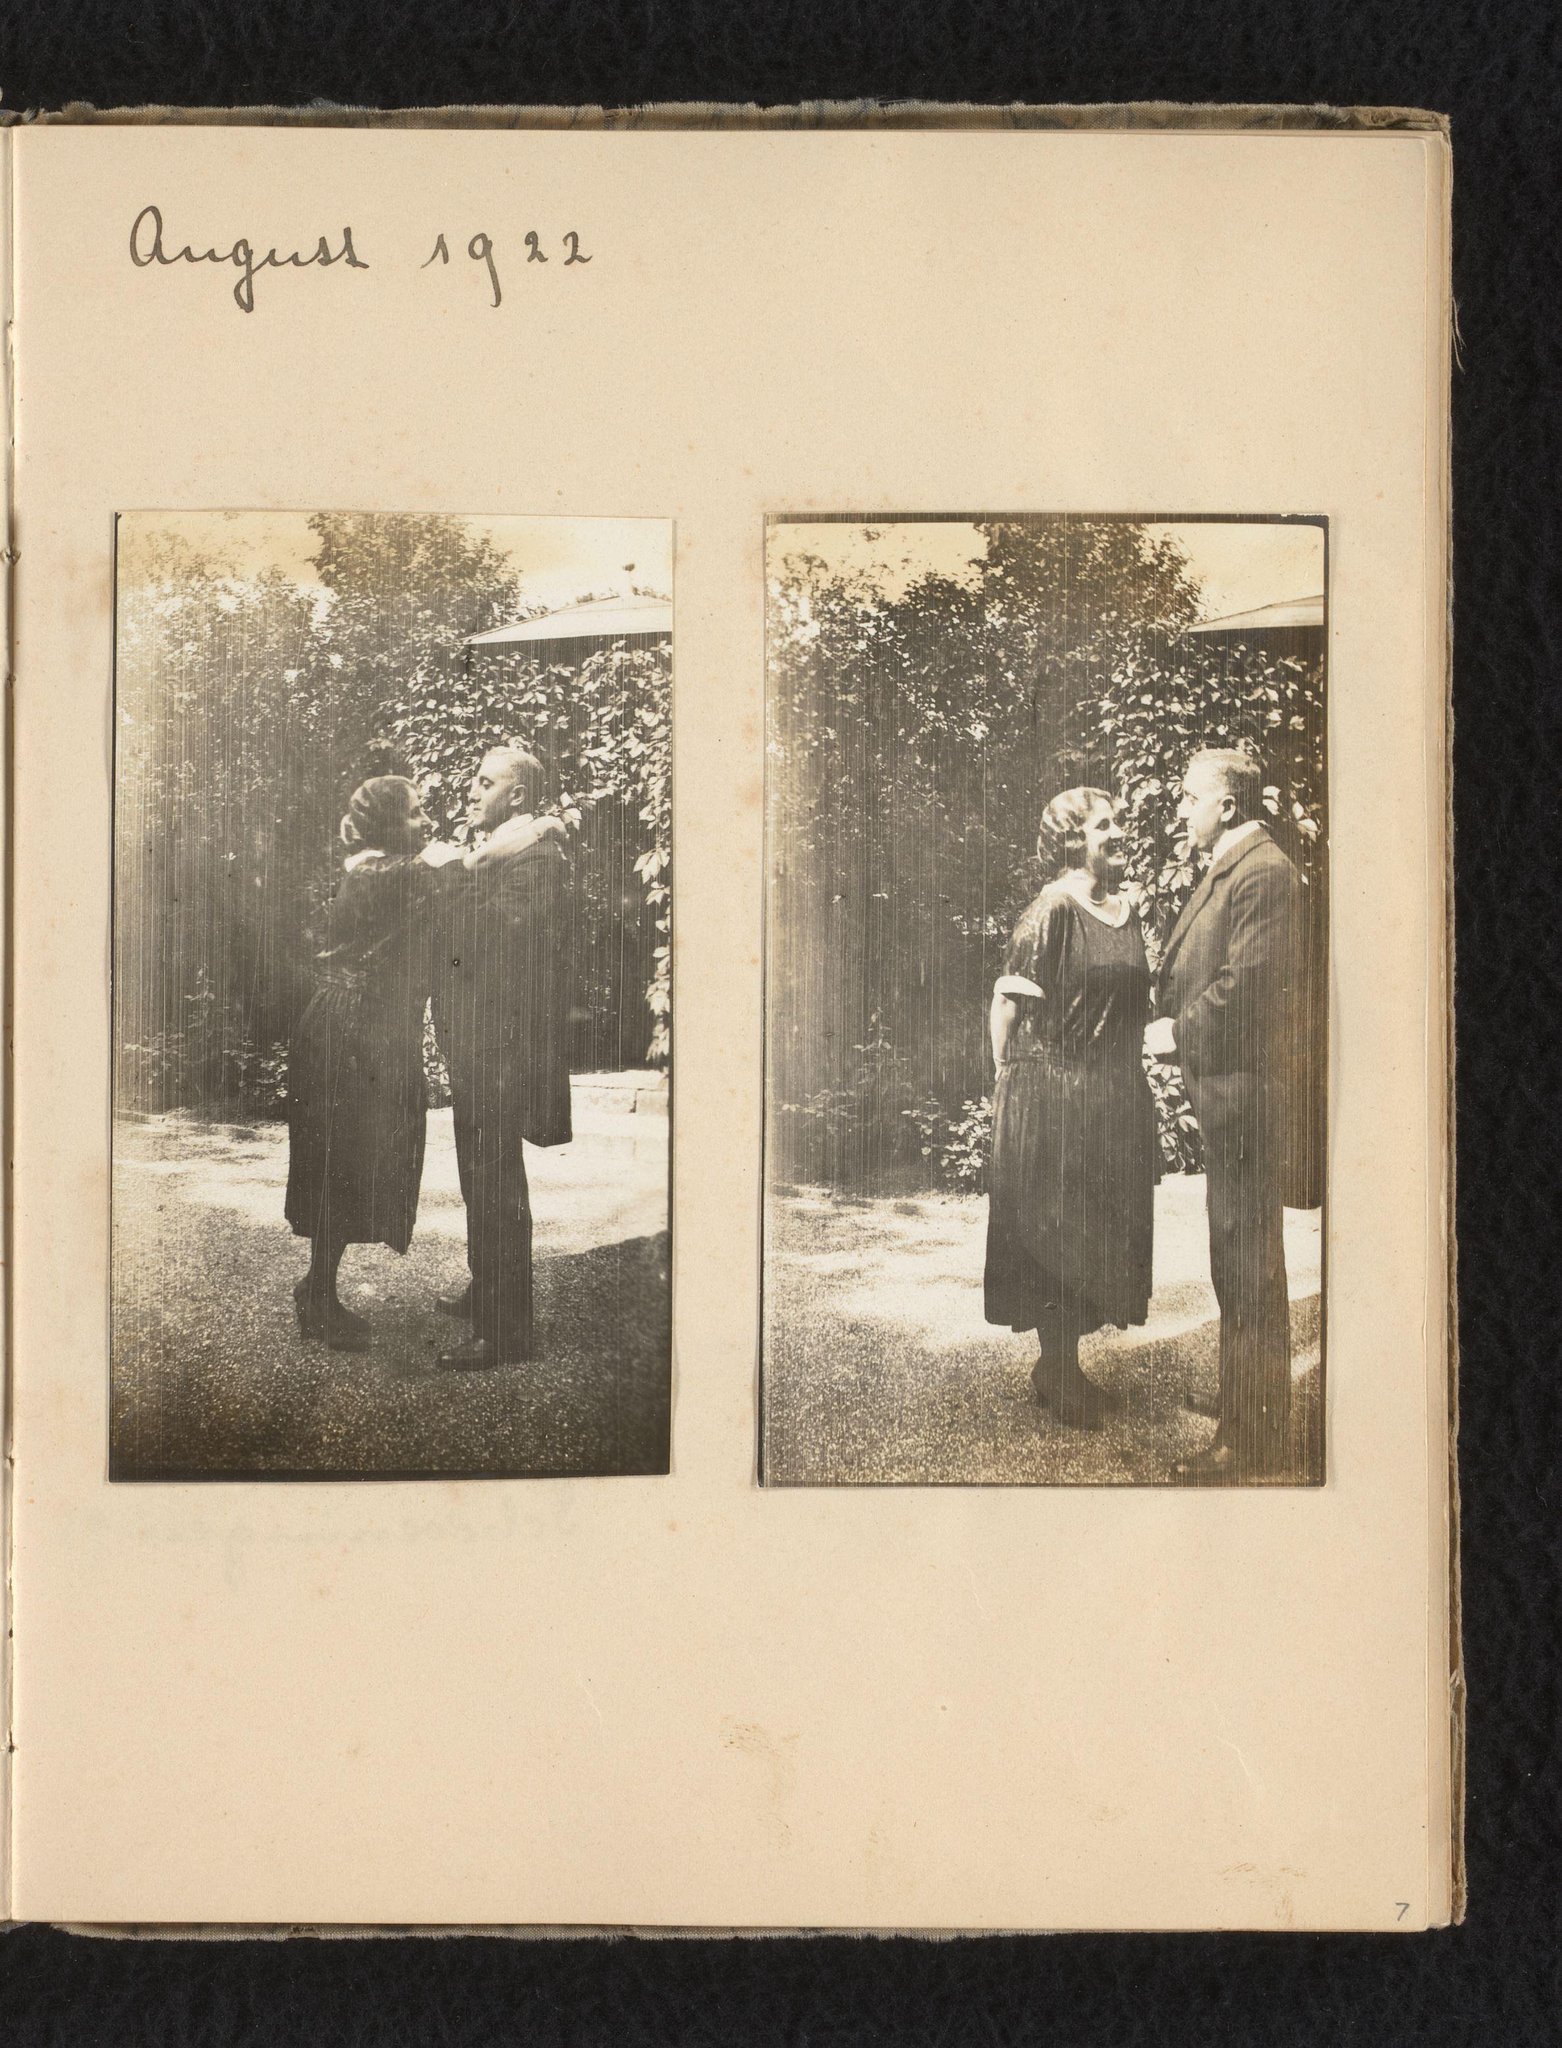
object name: album leaf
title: Else Wachenheimer-Moos en Eugen Wachenheimer in de tuin tijdens de dag van hun verloving, augustus 1922, Duitsland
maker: else wachenheimer-moos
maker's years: 1895-1944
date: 1908-1922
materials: paper, photographic support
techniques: gelatin silver print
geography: germany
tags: eugen wachenheimer, else wachenheimer-moos, the family travelling, on holiday, betrothal, germany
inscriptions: inscription: ‘August 1922’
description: Blad bevat twee foto's van Else Wachenheimer-Moos (links) en Eugen Wachenheimer (rechts). Onderdeel van het fotoalbum van de reizen die Eugen en Else Wachenheimer jaarlijks maakten rondom de viering van hun huwelijksdag en verloving.